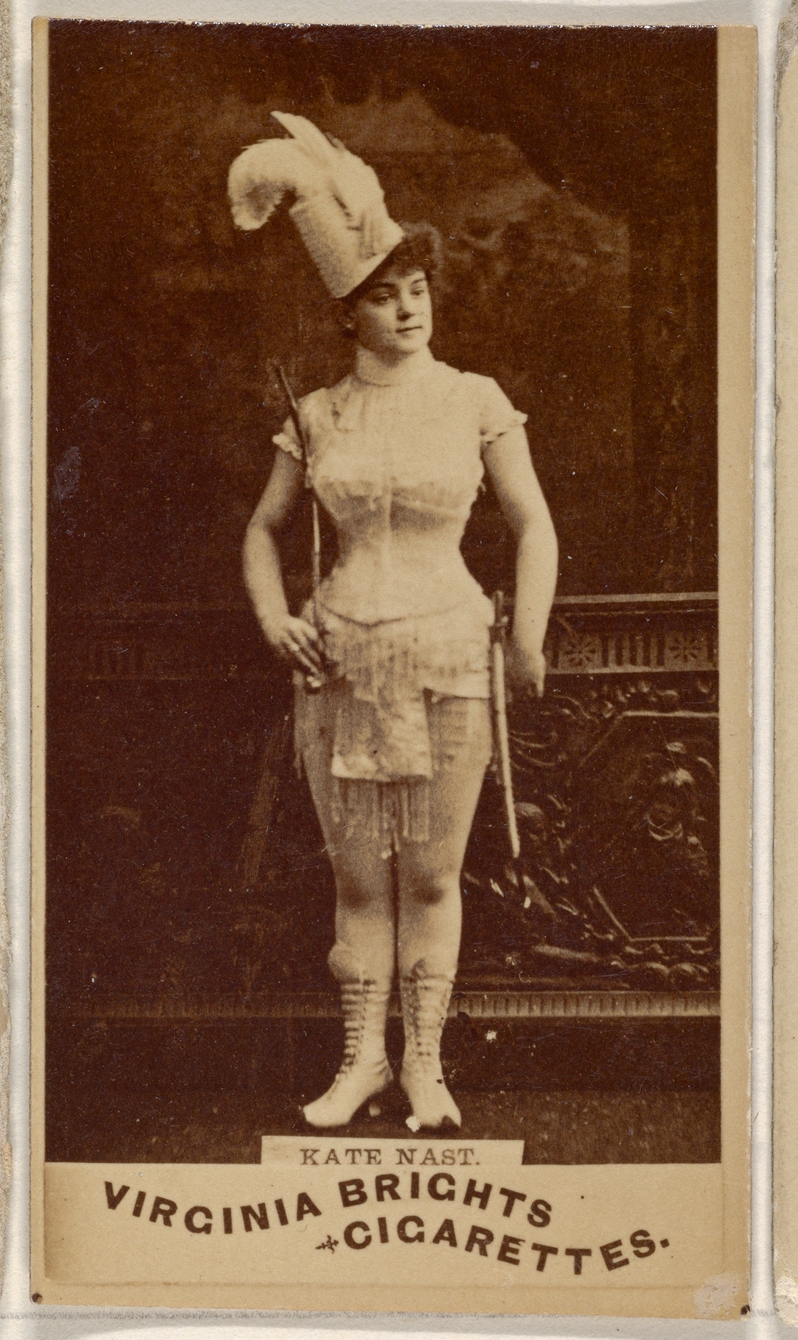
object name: photograph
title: Kate Nast, from the Actors and Actresses series (N45, Type 1) for Virginia Brights Cigarettes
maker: allen & ginter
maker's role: publisher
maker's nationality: american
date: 1888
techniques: albumen silver print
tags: portraits,women,actresses